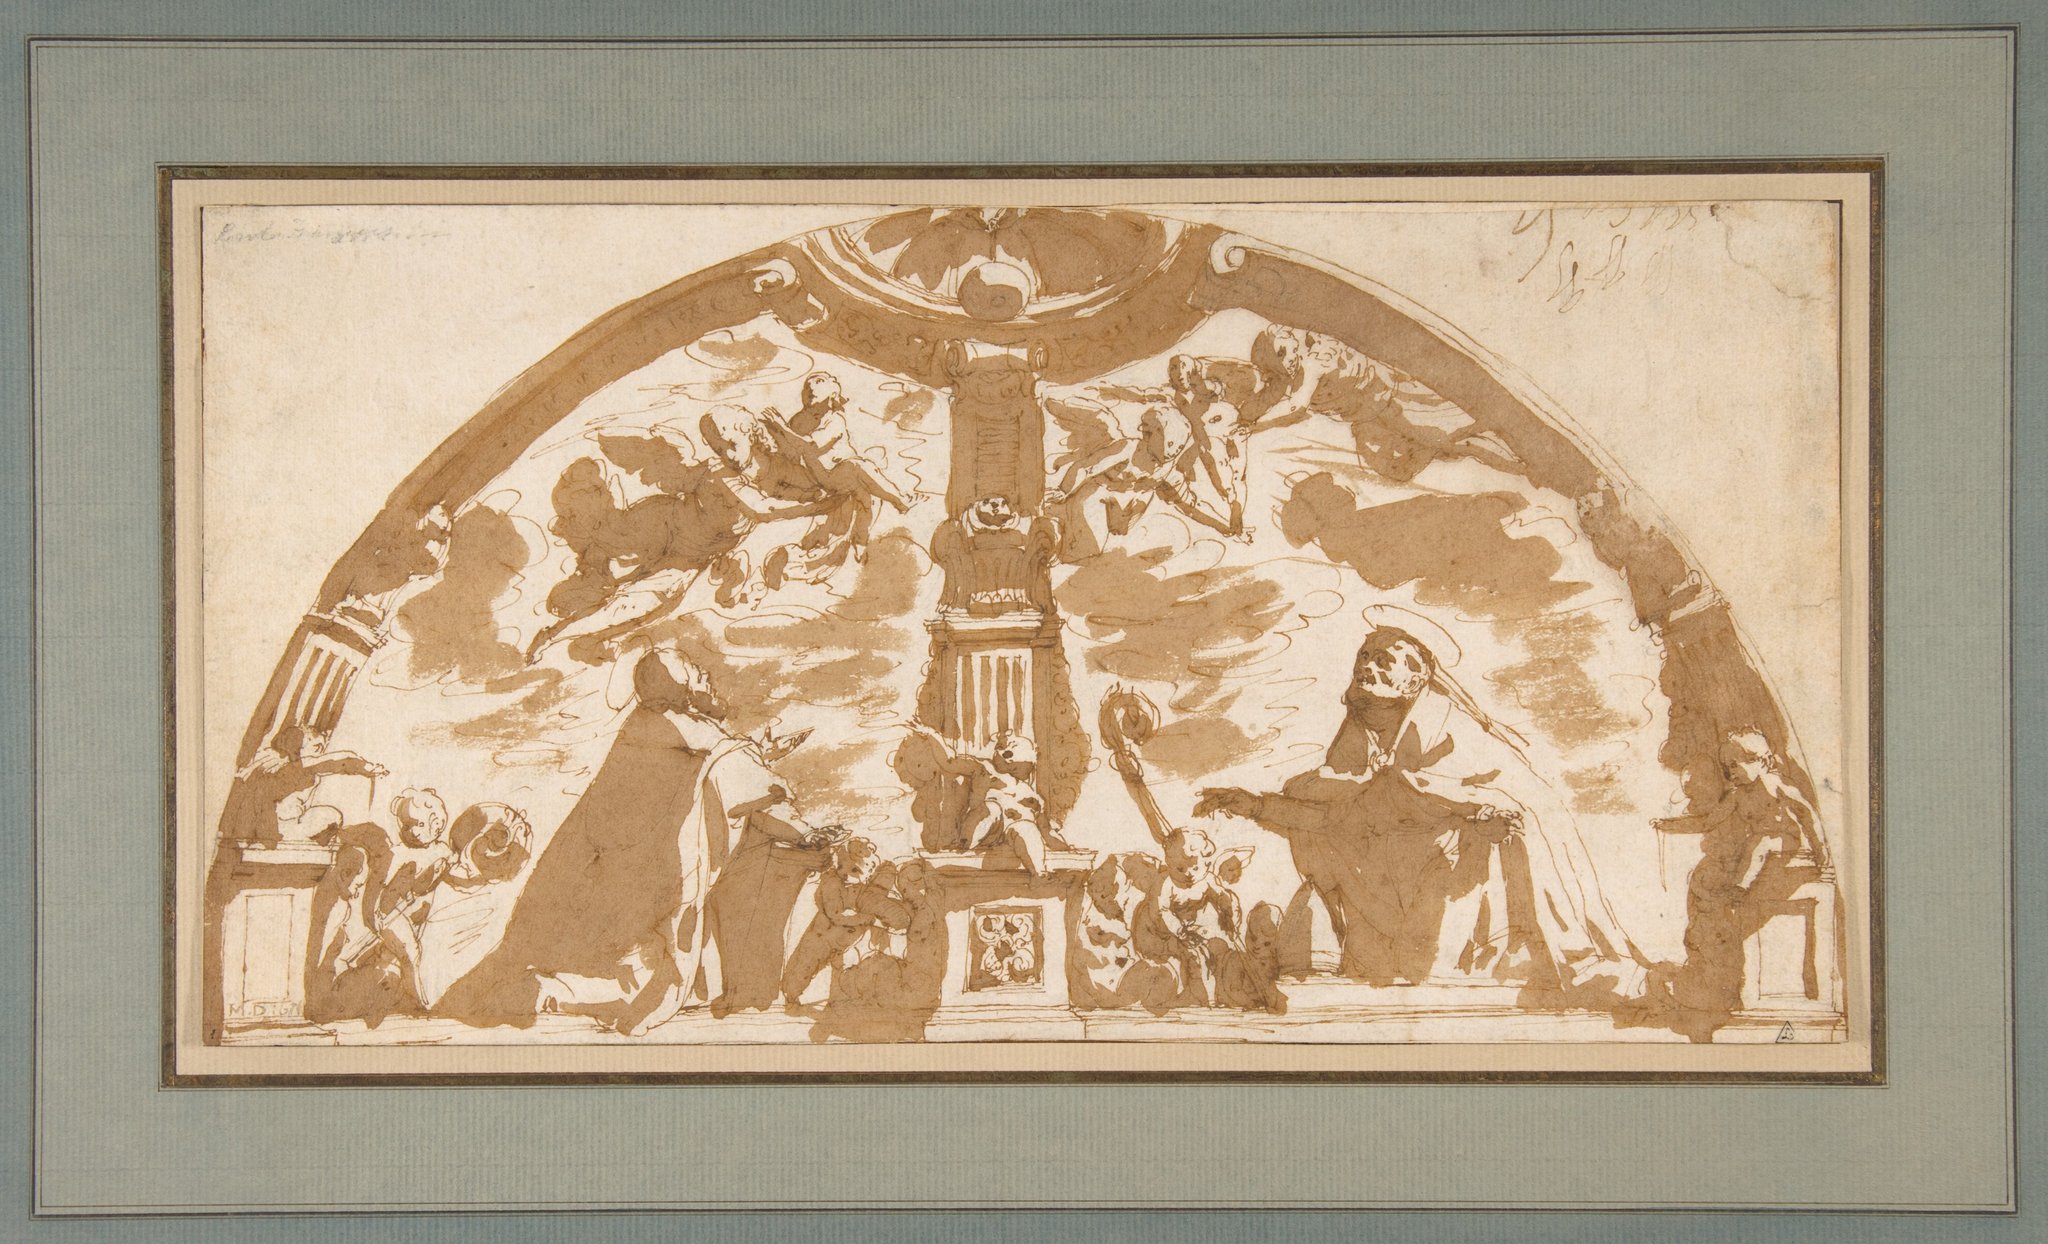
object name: drawing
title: Two Saints in Adoration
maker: ventura salimbeni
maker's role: artist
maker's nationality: italian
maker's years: 1568-1613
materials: ink, drawing material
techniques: brush, pen, wash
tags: saints